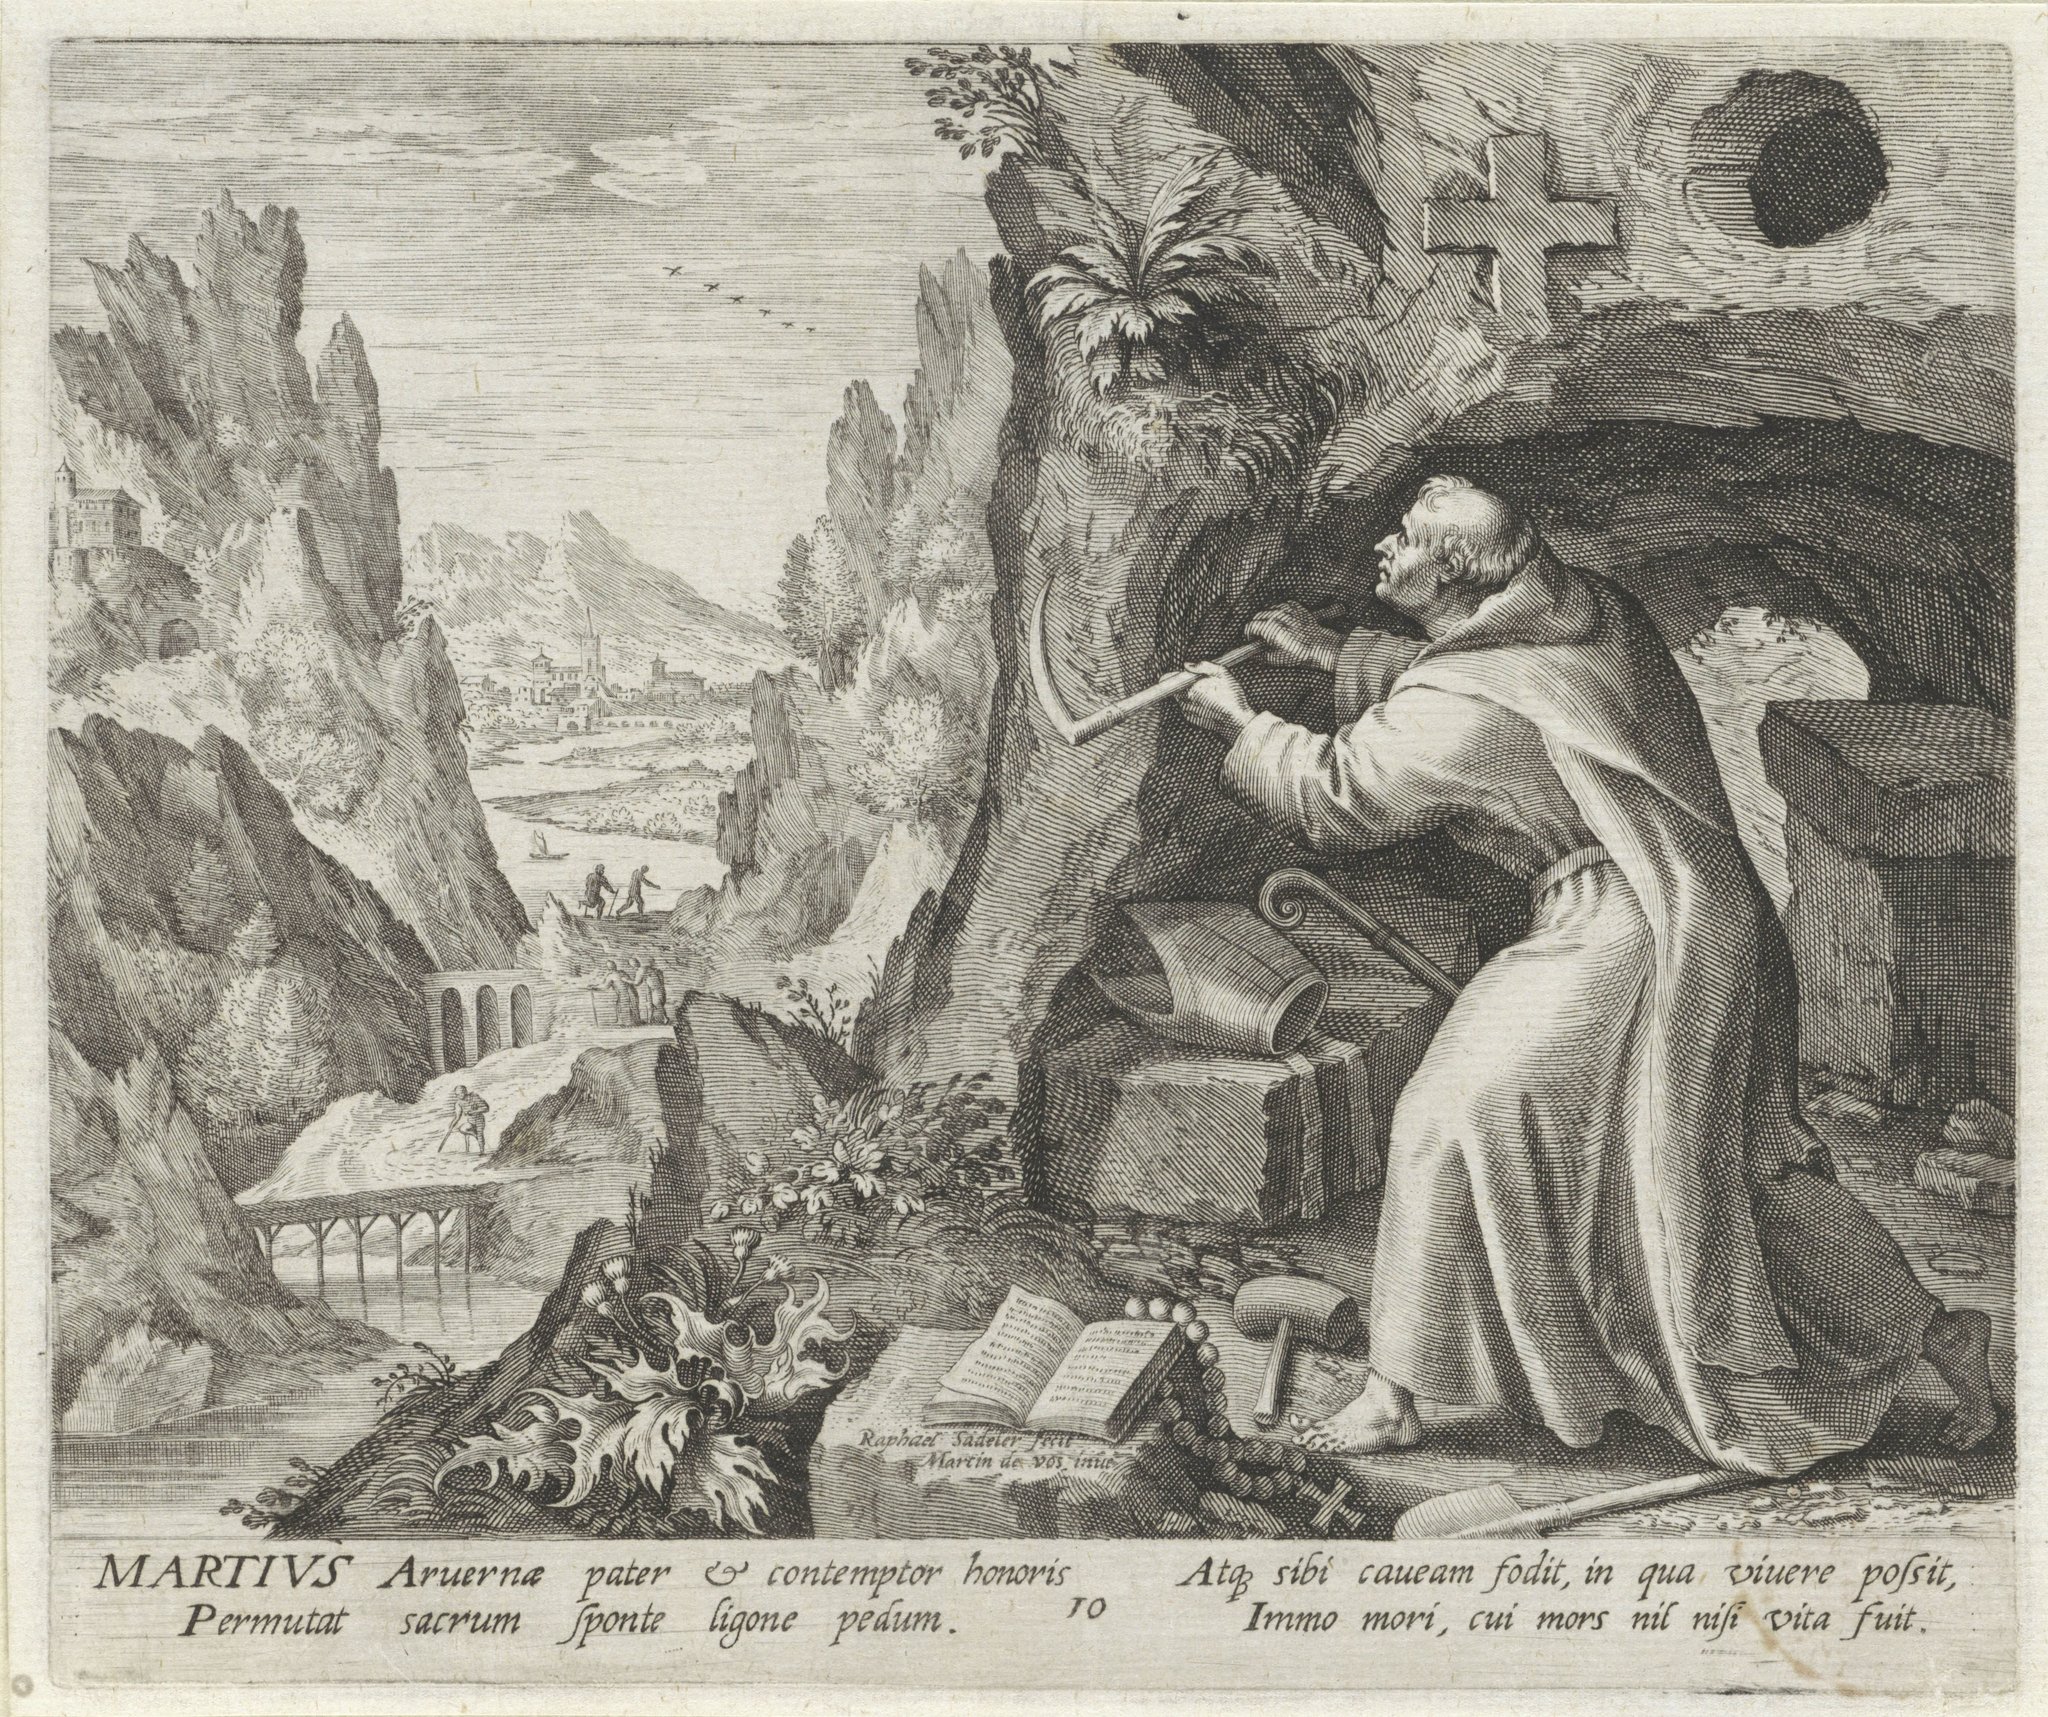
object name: print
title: Heilige Martius van Auvergne als kluizenaar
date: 1594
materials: paper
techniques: engraving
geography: munich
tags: male saints (martius), anchorite, hermit, cave, grotto, mountains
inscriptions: collector's mark: Lugt 240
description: H. Martius van Auvergne, een vroeg-christelijke kluizenaar, voor een grot in een bergachtig landschap. Hij slaat met een zeis tegen een rots.